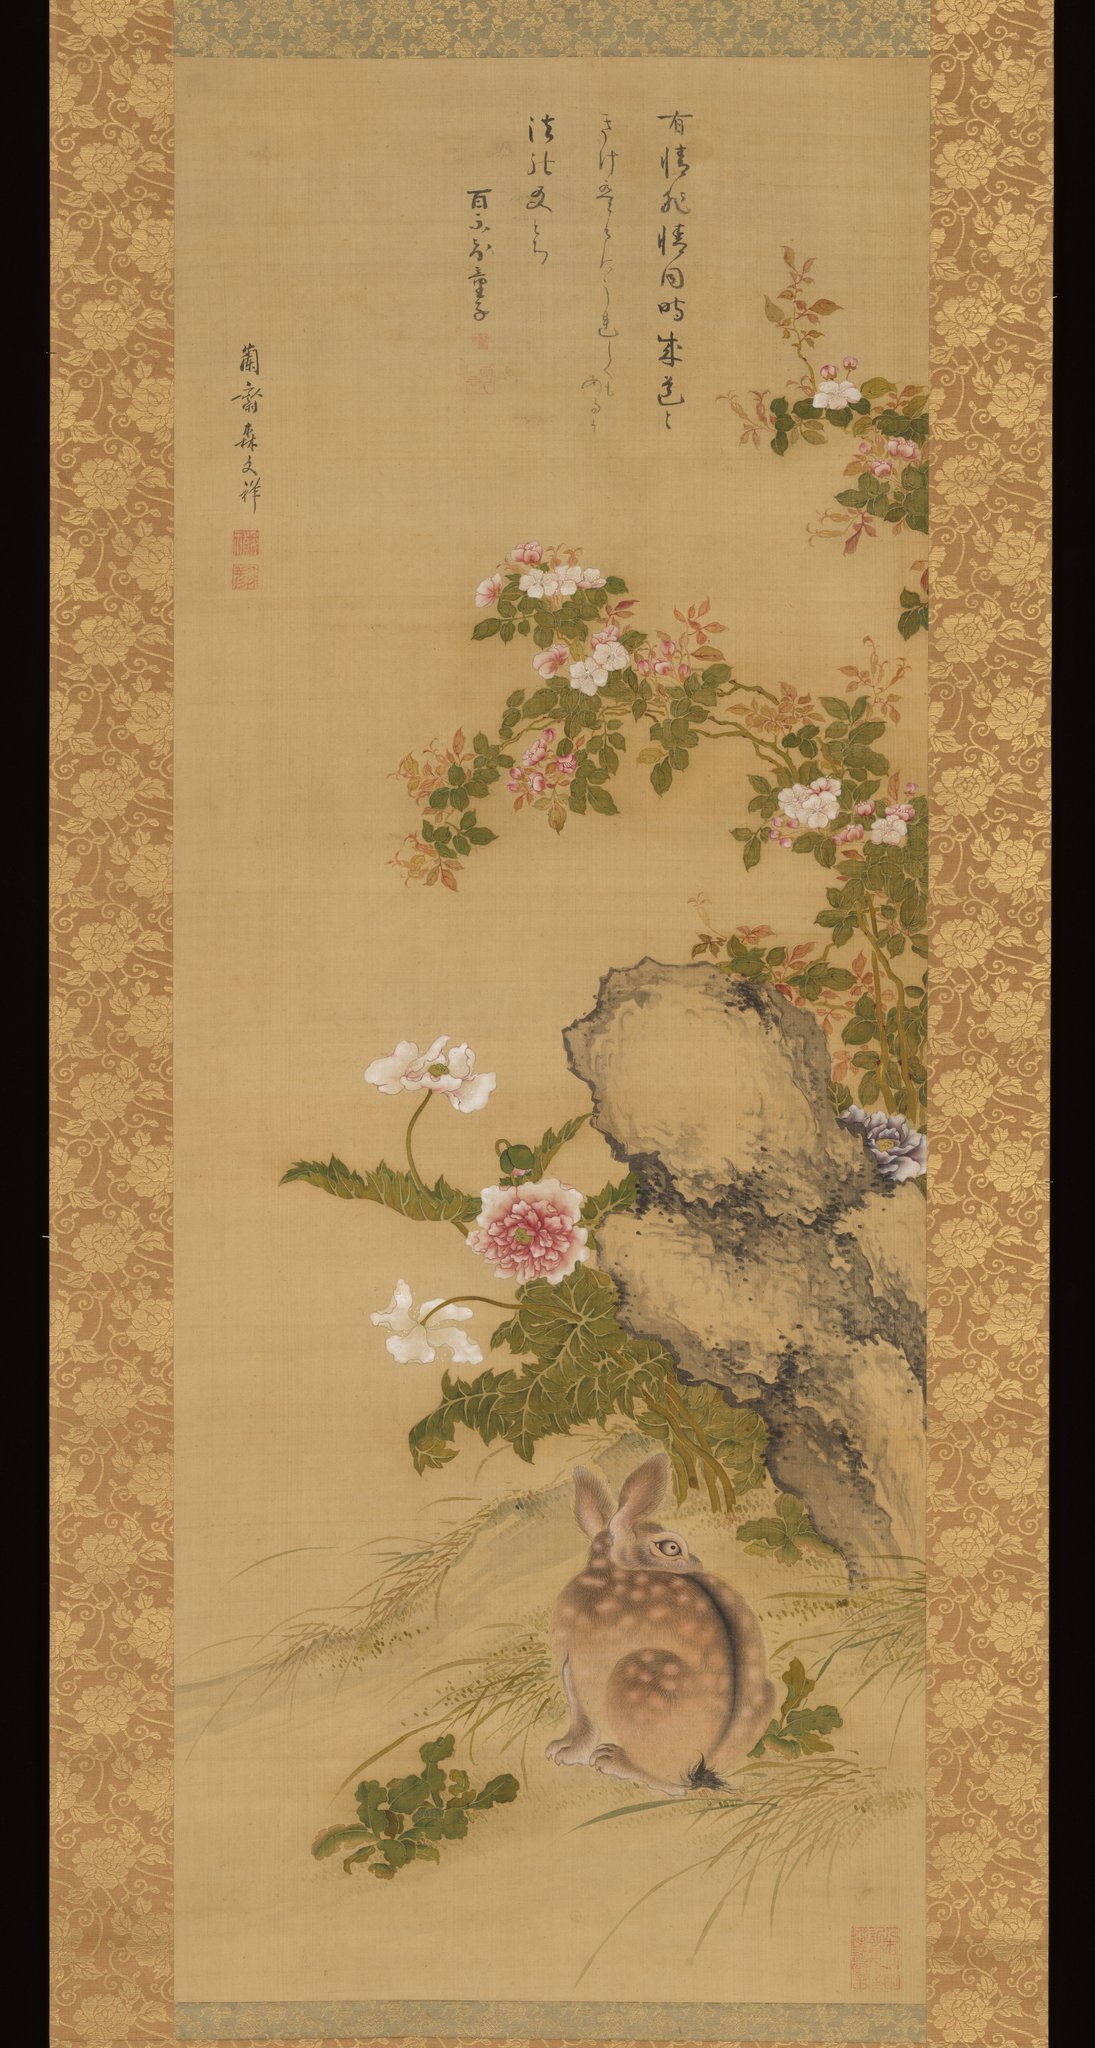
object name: hanging scroll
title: Rabbit and Roses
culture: japanese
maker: mori ransai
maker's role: artist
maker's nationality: japanese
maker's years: 1731-1801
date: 1776-1783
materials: ink, silk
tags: rabbits,roses